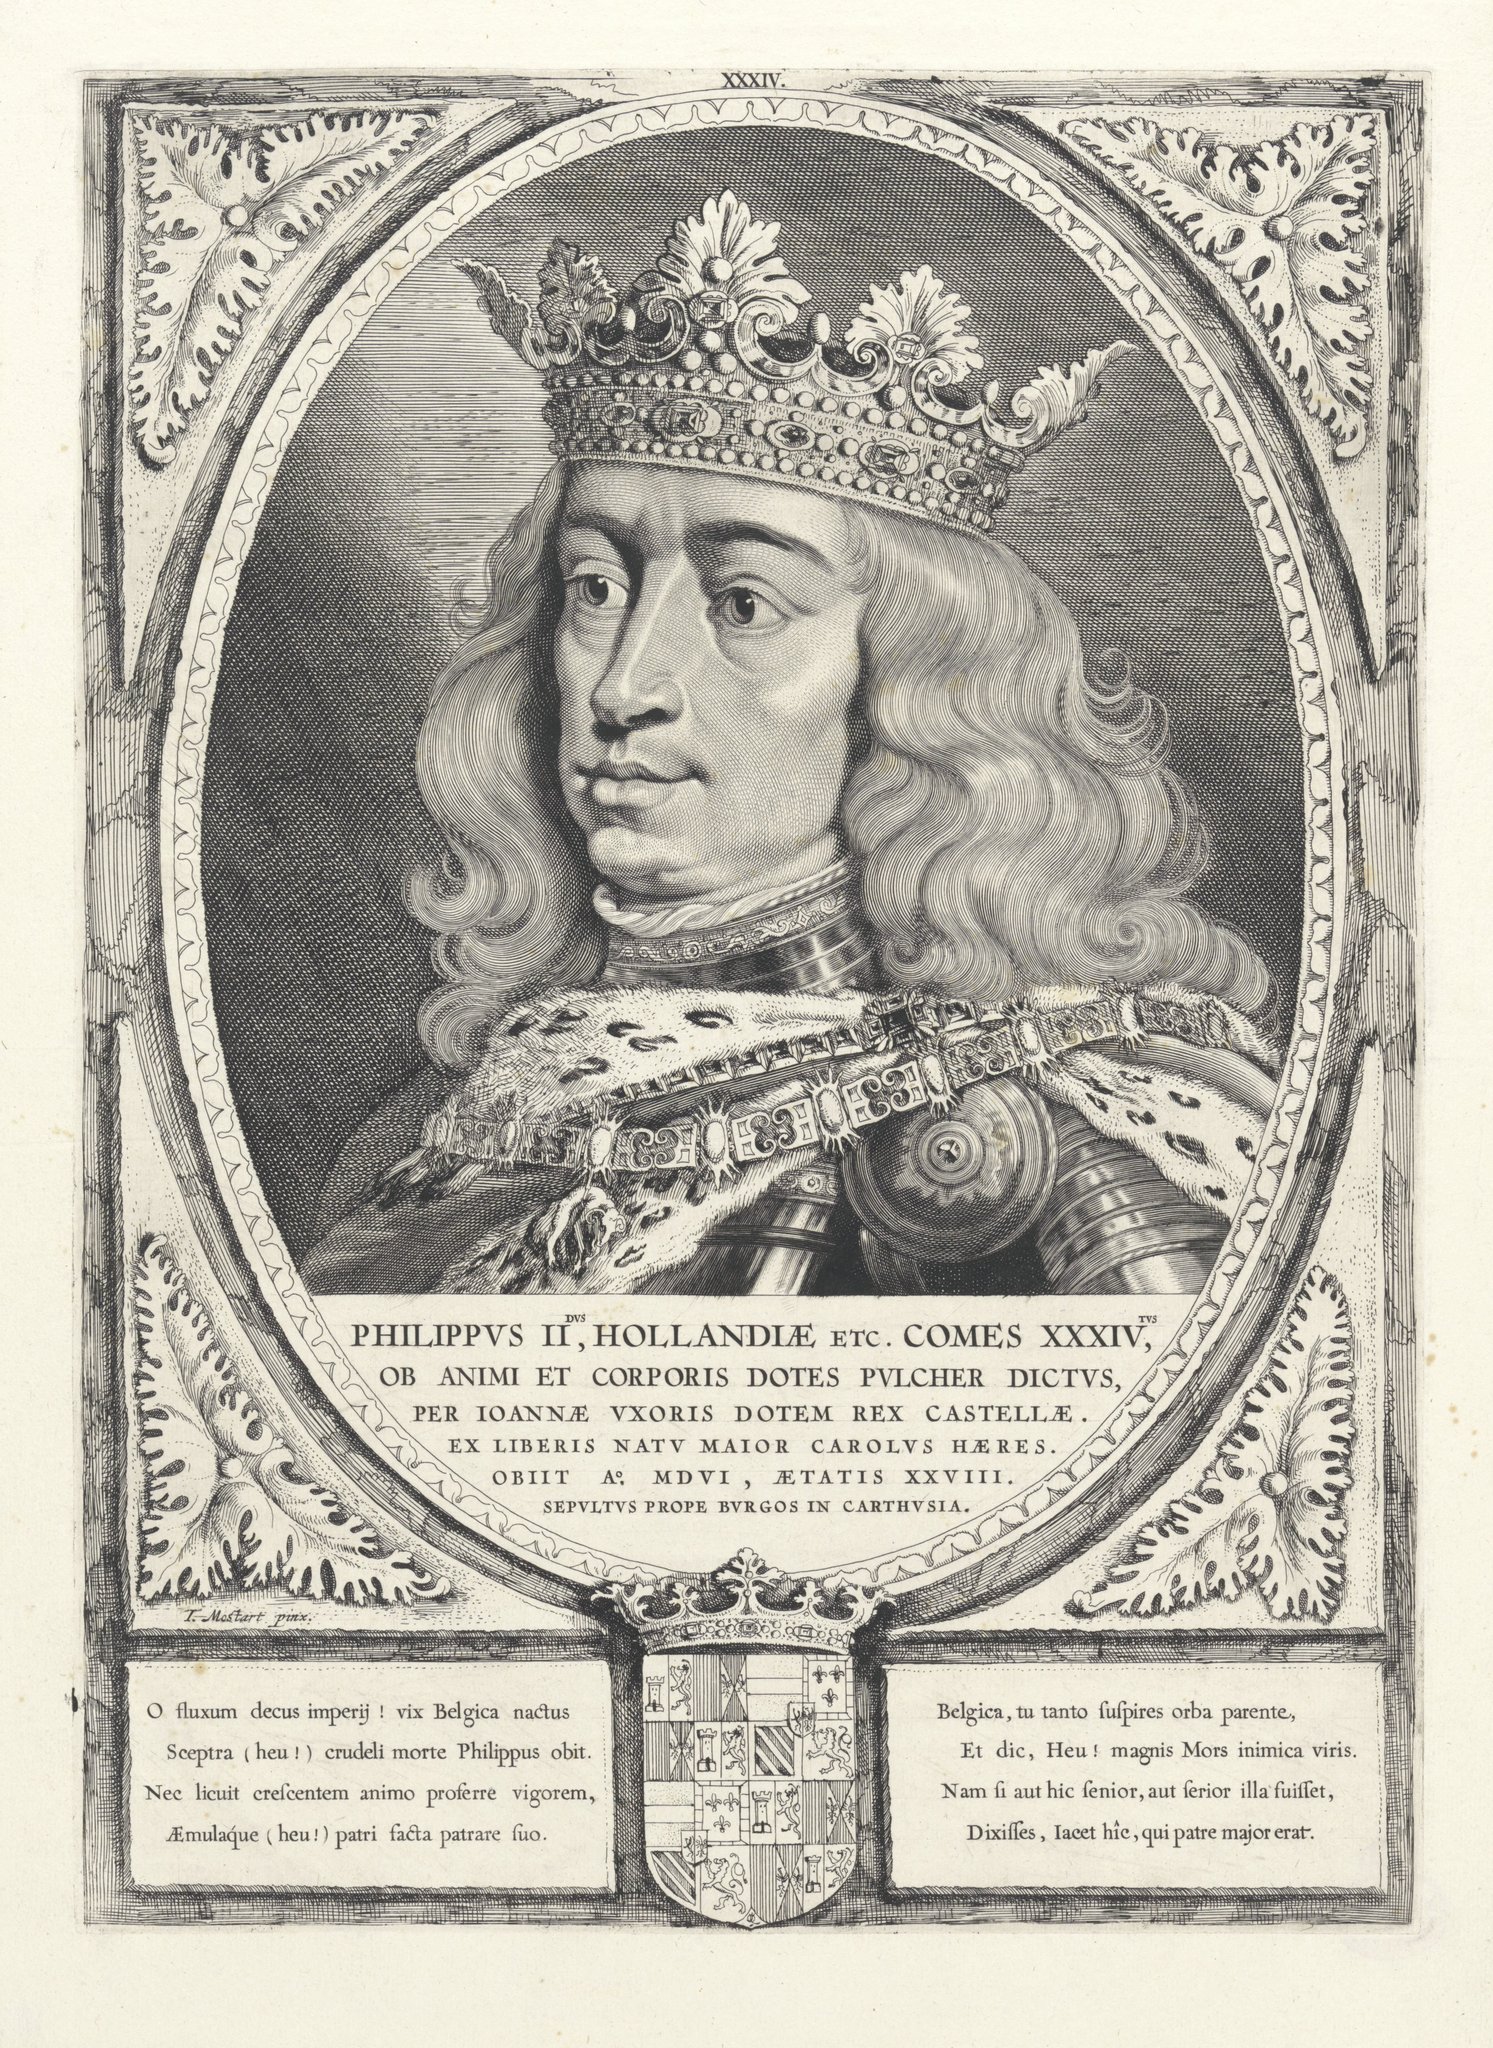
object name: print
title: Portret van Filips de Schone, hertog van Bourgondië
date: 1650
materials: paper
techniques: engraving, etching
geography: haarlem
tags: bruges, filips de schone (hertog van bourgondië), crown (symbol of sovereignty), armour, knighthood order of the golden fleece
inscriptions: collector's mark: Lugt 12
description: Filips de Schone, hertog van Bourgondië, met een kroon, een koningsmantel en om zijn hals een keten met het ordeteken van de orde van het gulden vlies.